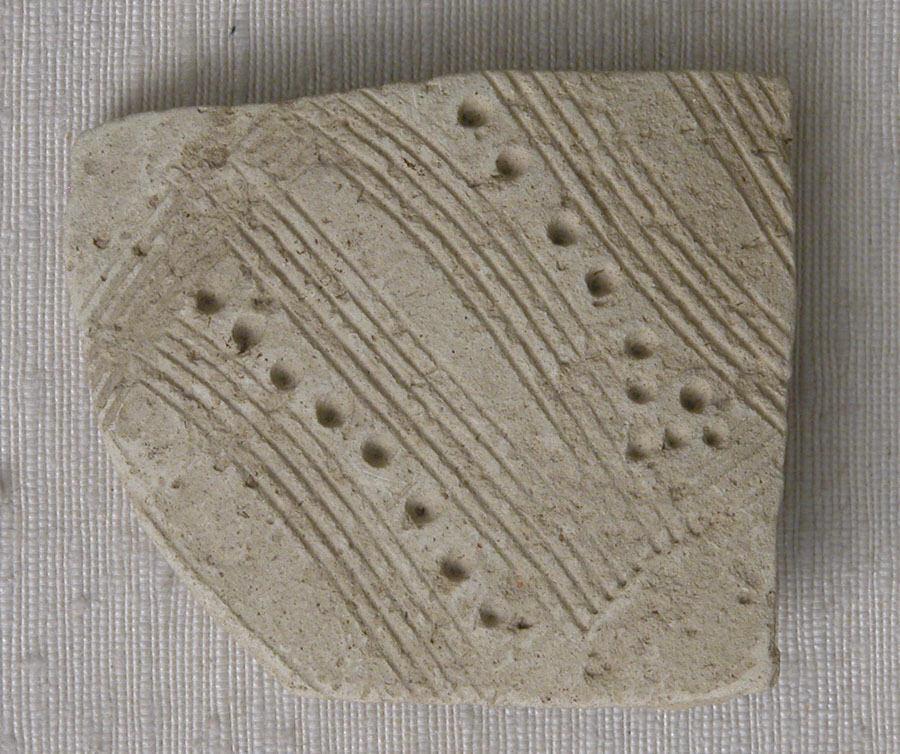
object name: fragment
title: Ceramic Fragment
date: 701-900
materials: earthenware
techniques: incising, stamping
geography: iraq